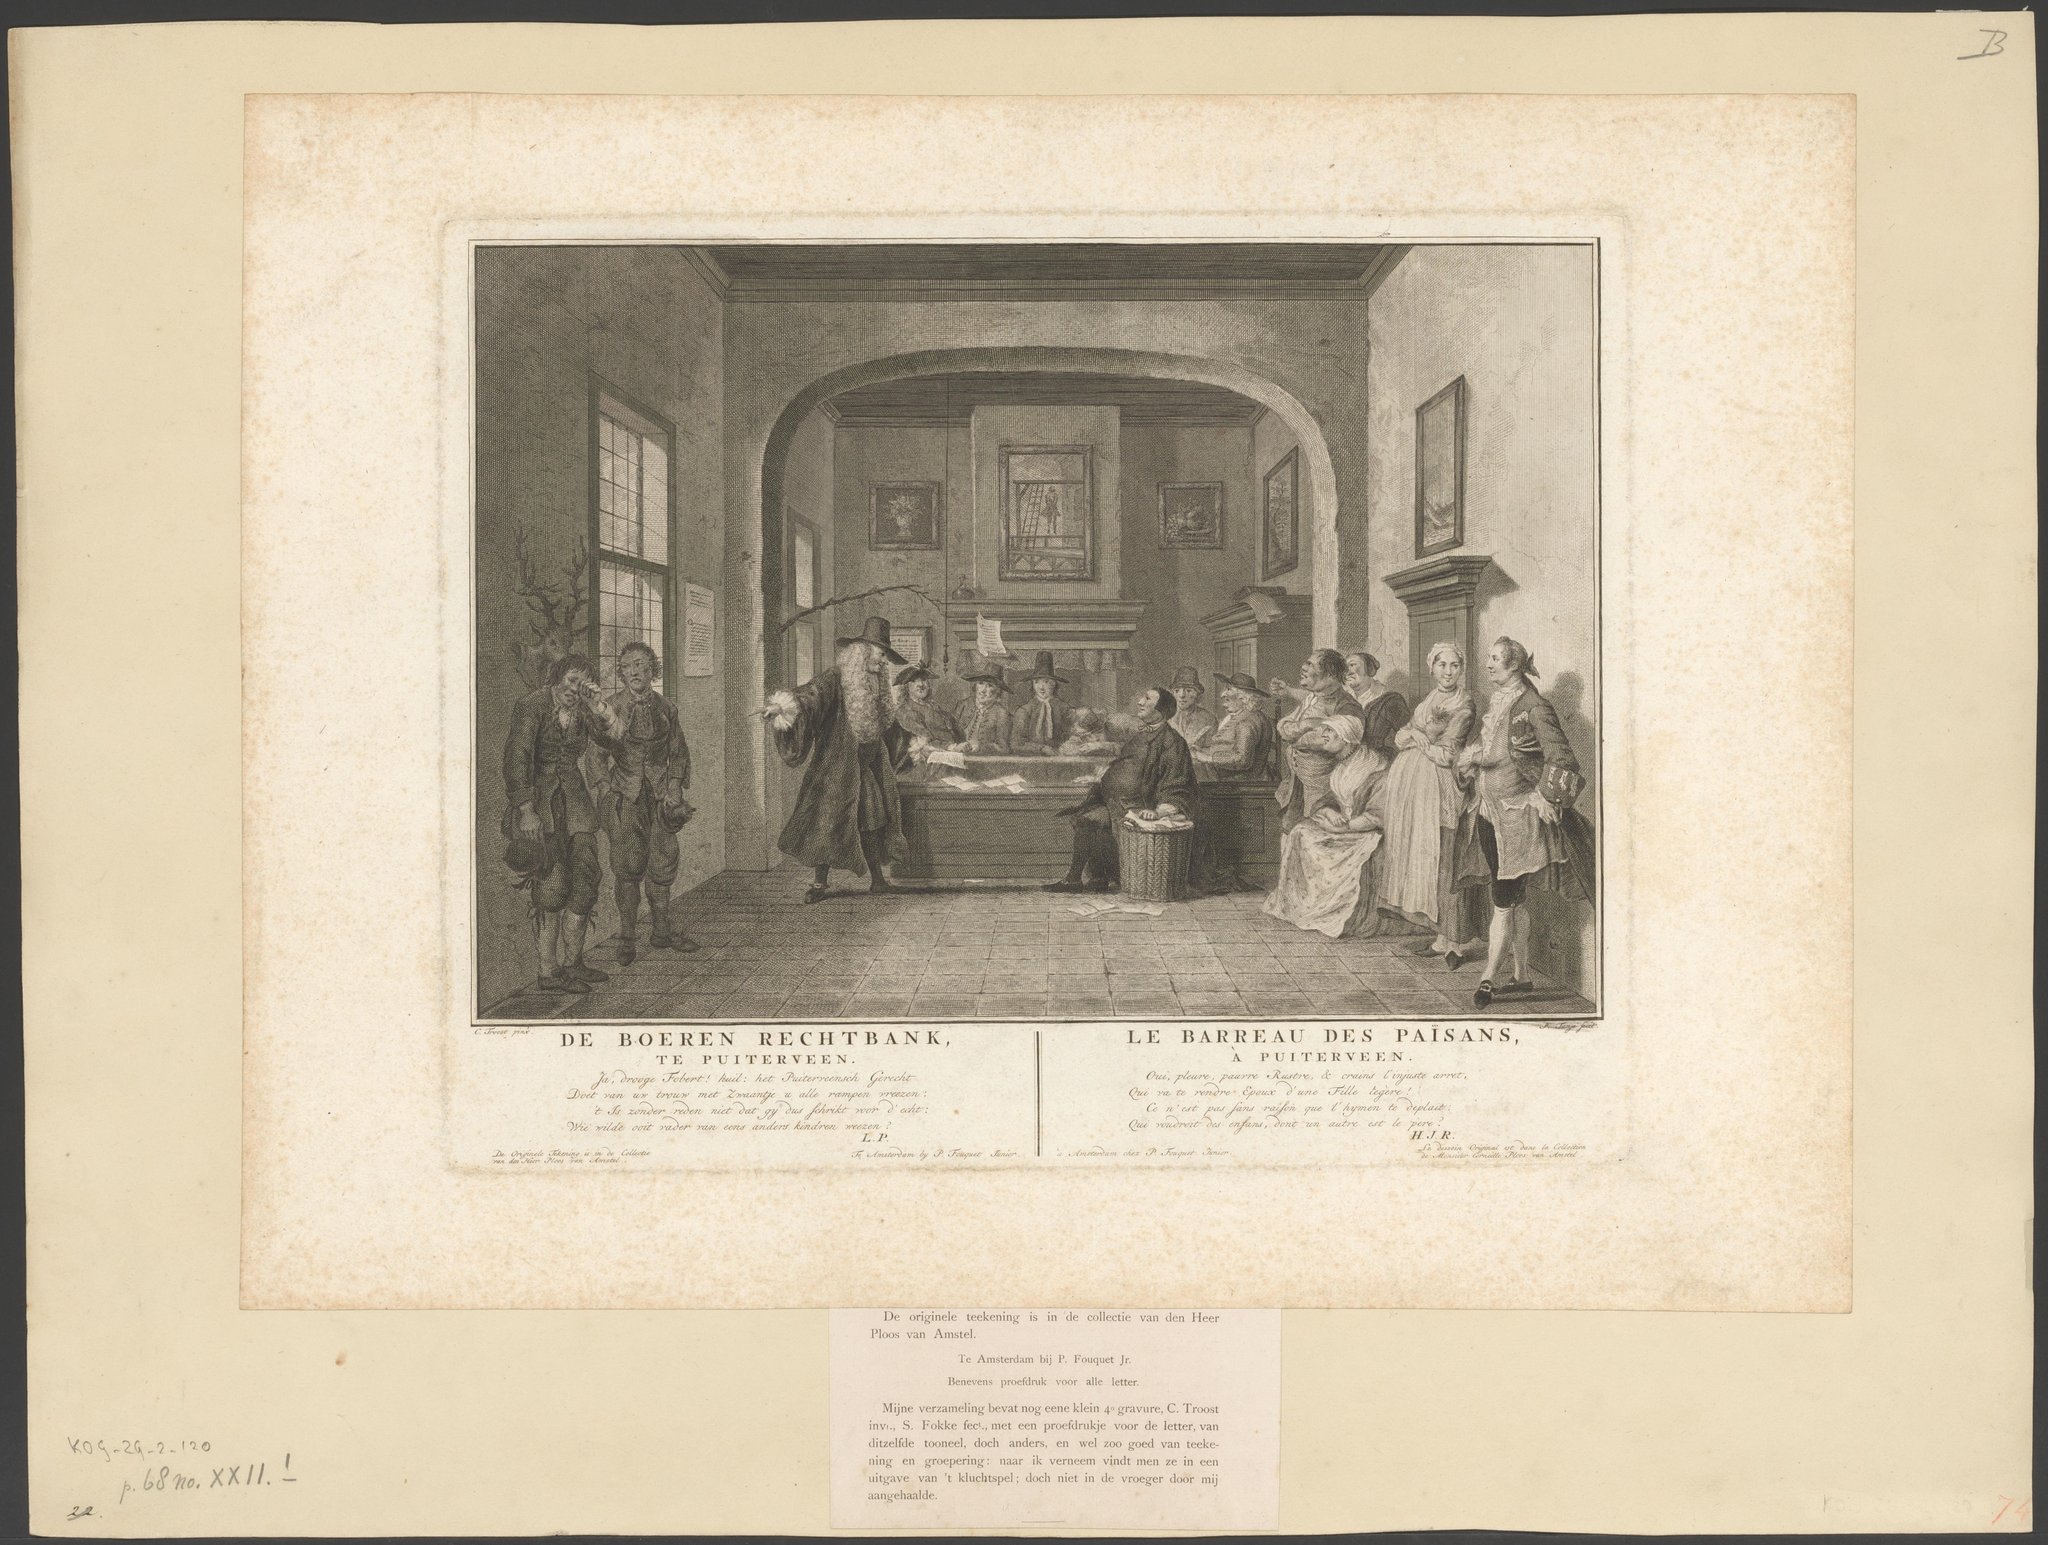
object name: print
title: De boerenrechtbank te Puiterveen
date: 1754-1764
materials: paper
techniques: engraving, etching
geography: amsterdam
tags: lawyer, attorney at law, pregnant woman, comedy, court-room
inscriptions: collector's mark: Lugt 2488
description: Voor de boerenrechtbank van Puiterveen staan links de huilende Fobert en zijn vader en rechts de zwangere Swaantje tussen jonker Jan en haar ouders. Swaantje is bezwangerd door de zoon van de heer van Puijterveen, maar Fobert wordt van deze daad beschuldigd. De corrupte advocaat van Fobert is aan het pleiten, terwijl de advocaat van de tegenpartij toehoort. Achter de tafel zitten schout en schepenen. Onderaan in de marge een vierregelig vers in het Nederlands en het Frans. Scène uit het derde bedrijf van het toneelstuk Beslikte Swaantje, en Drooge Fobert; of de boere rechtbank, van Abraham Alewijn.